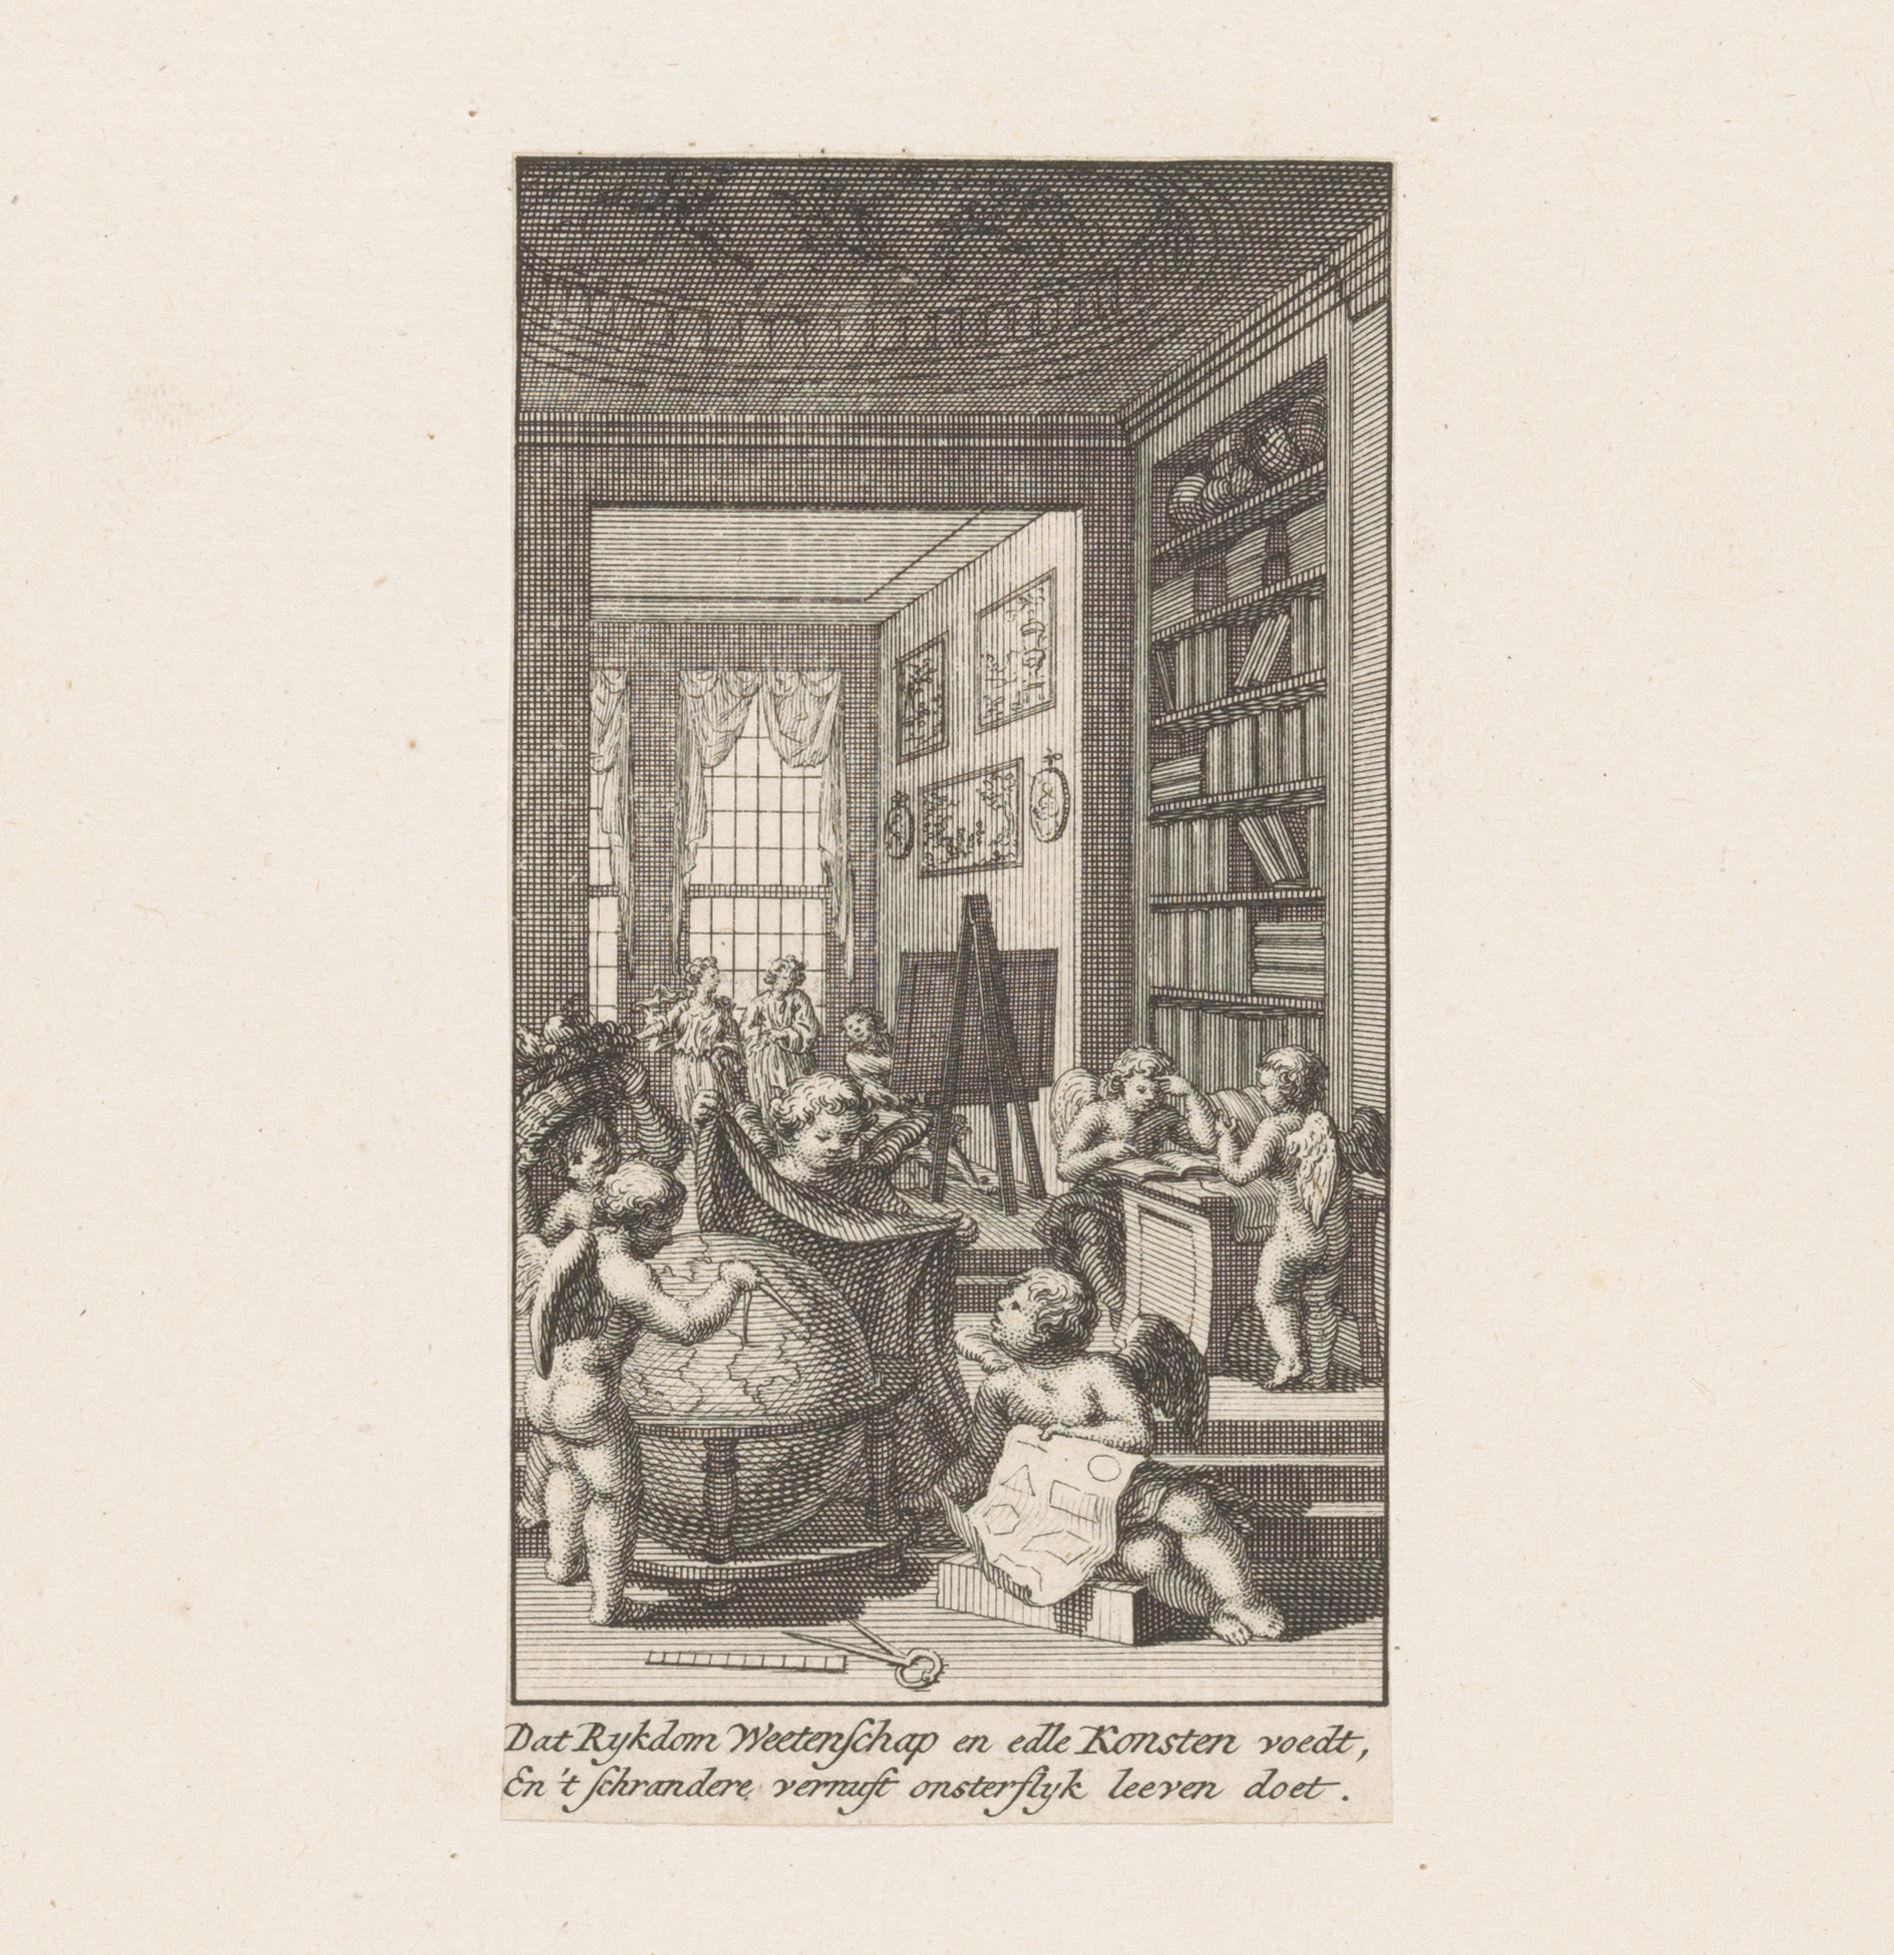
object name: print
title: Studeervertrek met putti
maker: Anonymous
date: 1700-1799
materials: paper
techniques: etching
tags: bookshelves, easel, globe, cupids: 'amores', 'amoretti', 'putti'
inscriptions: collector's mark: Lugt 2228, collector's mark: Lugt 4780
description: Op de voorgrond een putto met een blad met geometrische figuren en twee putti rond een wereldbol. Rechts twee lezende putti voor een boekenkast. Voor het raam in de achtergrond een schilder achter een ezel en twee toeschouwers.